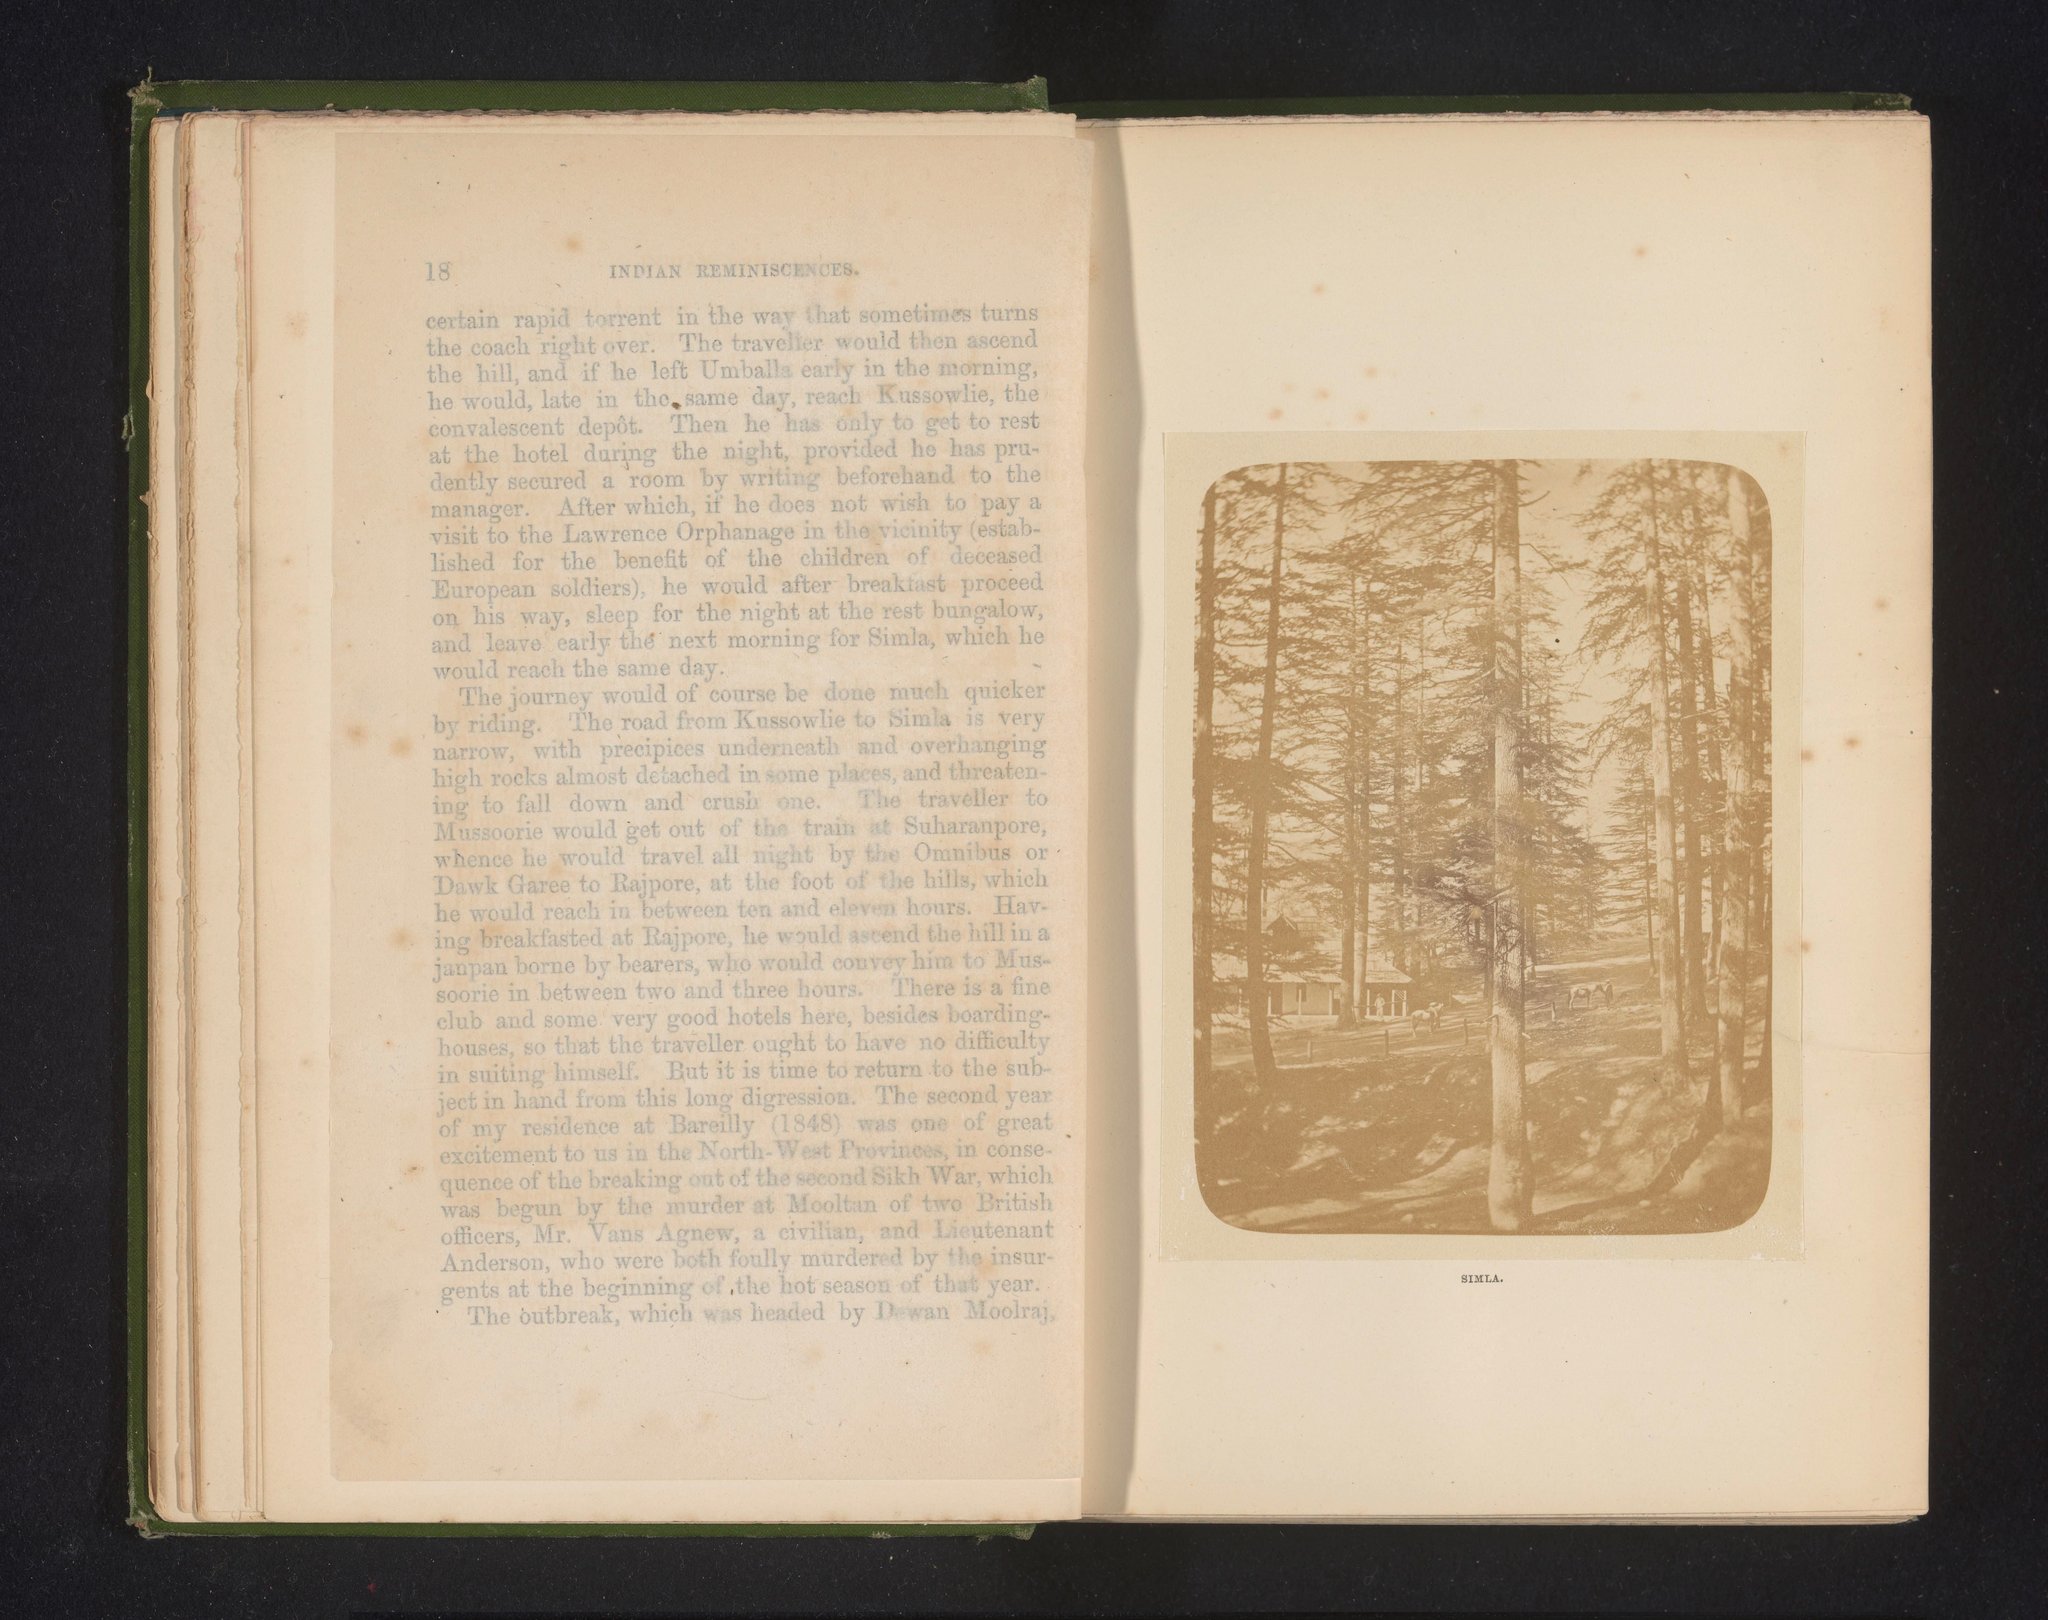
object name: photograph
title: Simla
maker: Anonymous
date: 1870-1880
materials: photographic support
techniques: albumen print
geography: shimla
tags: fence, wall, paling, horse